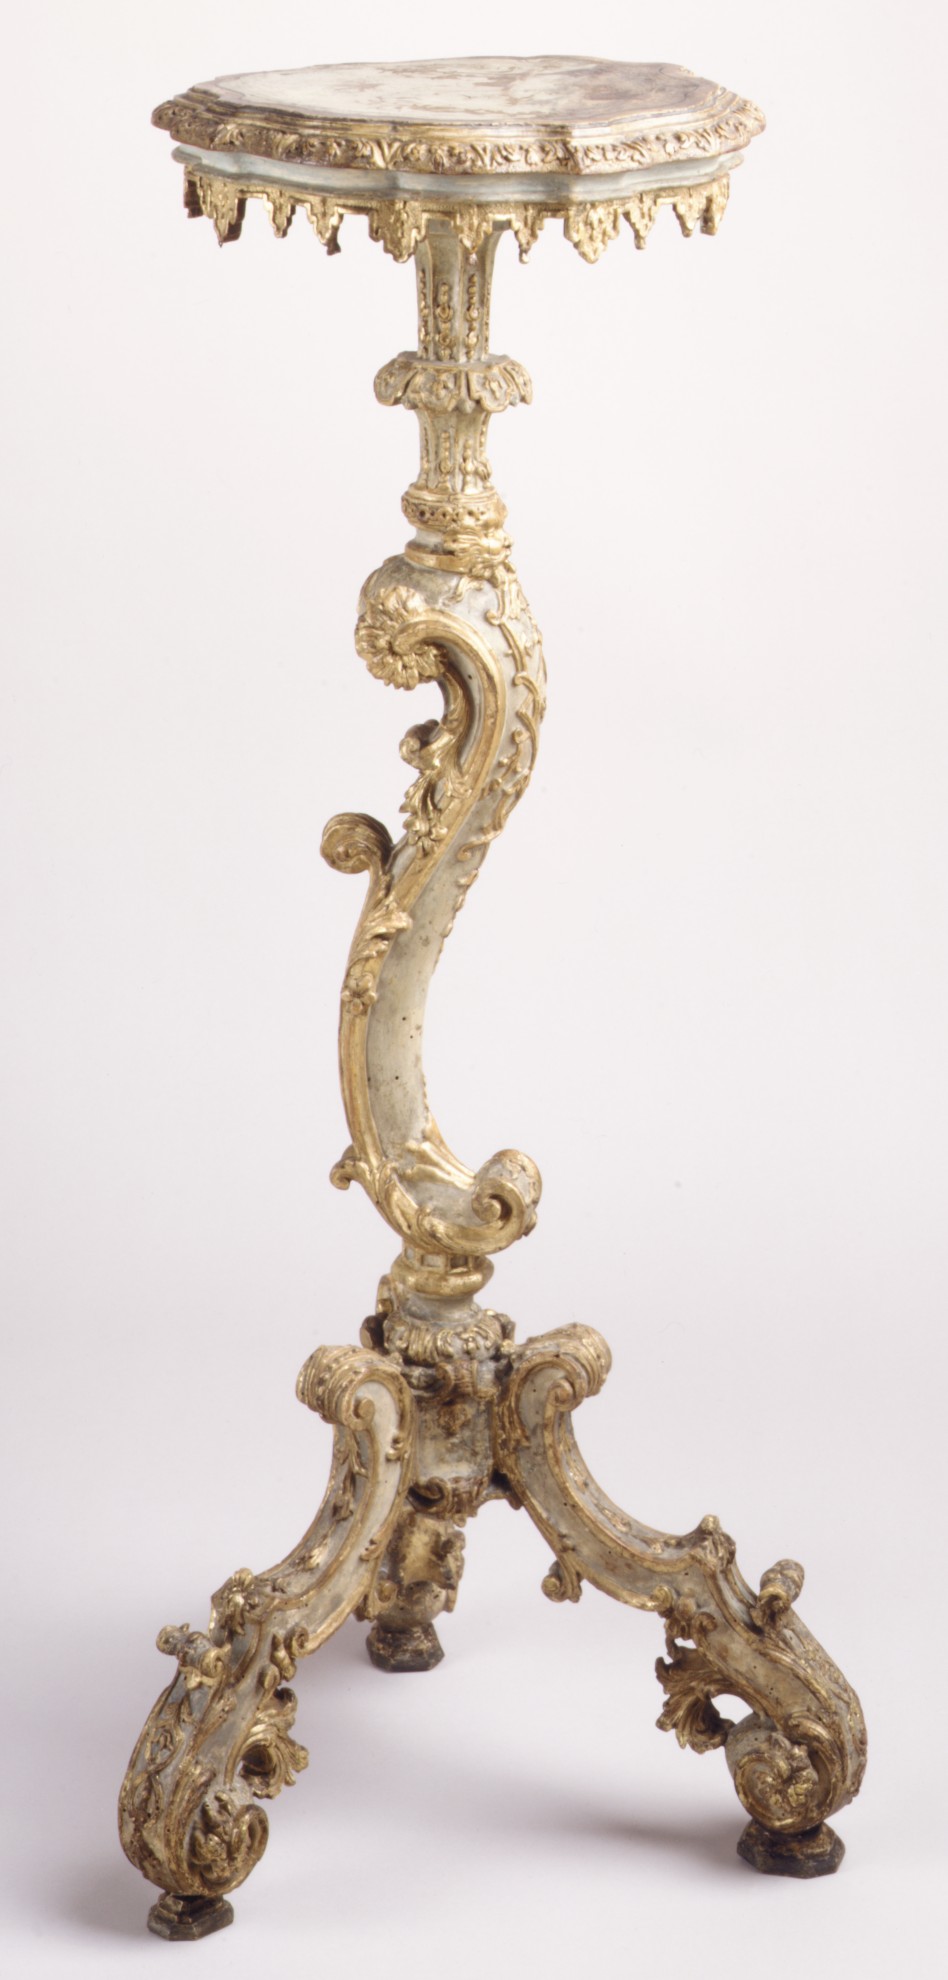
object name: candlestand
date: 1750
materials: wood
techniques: gilding, painting